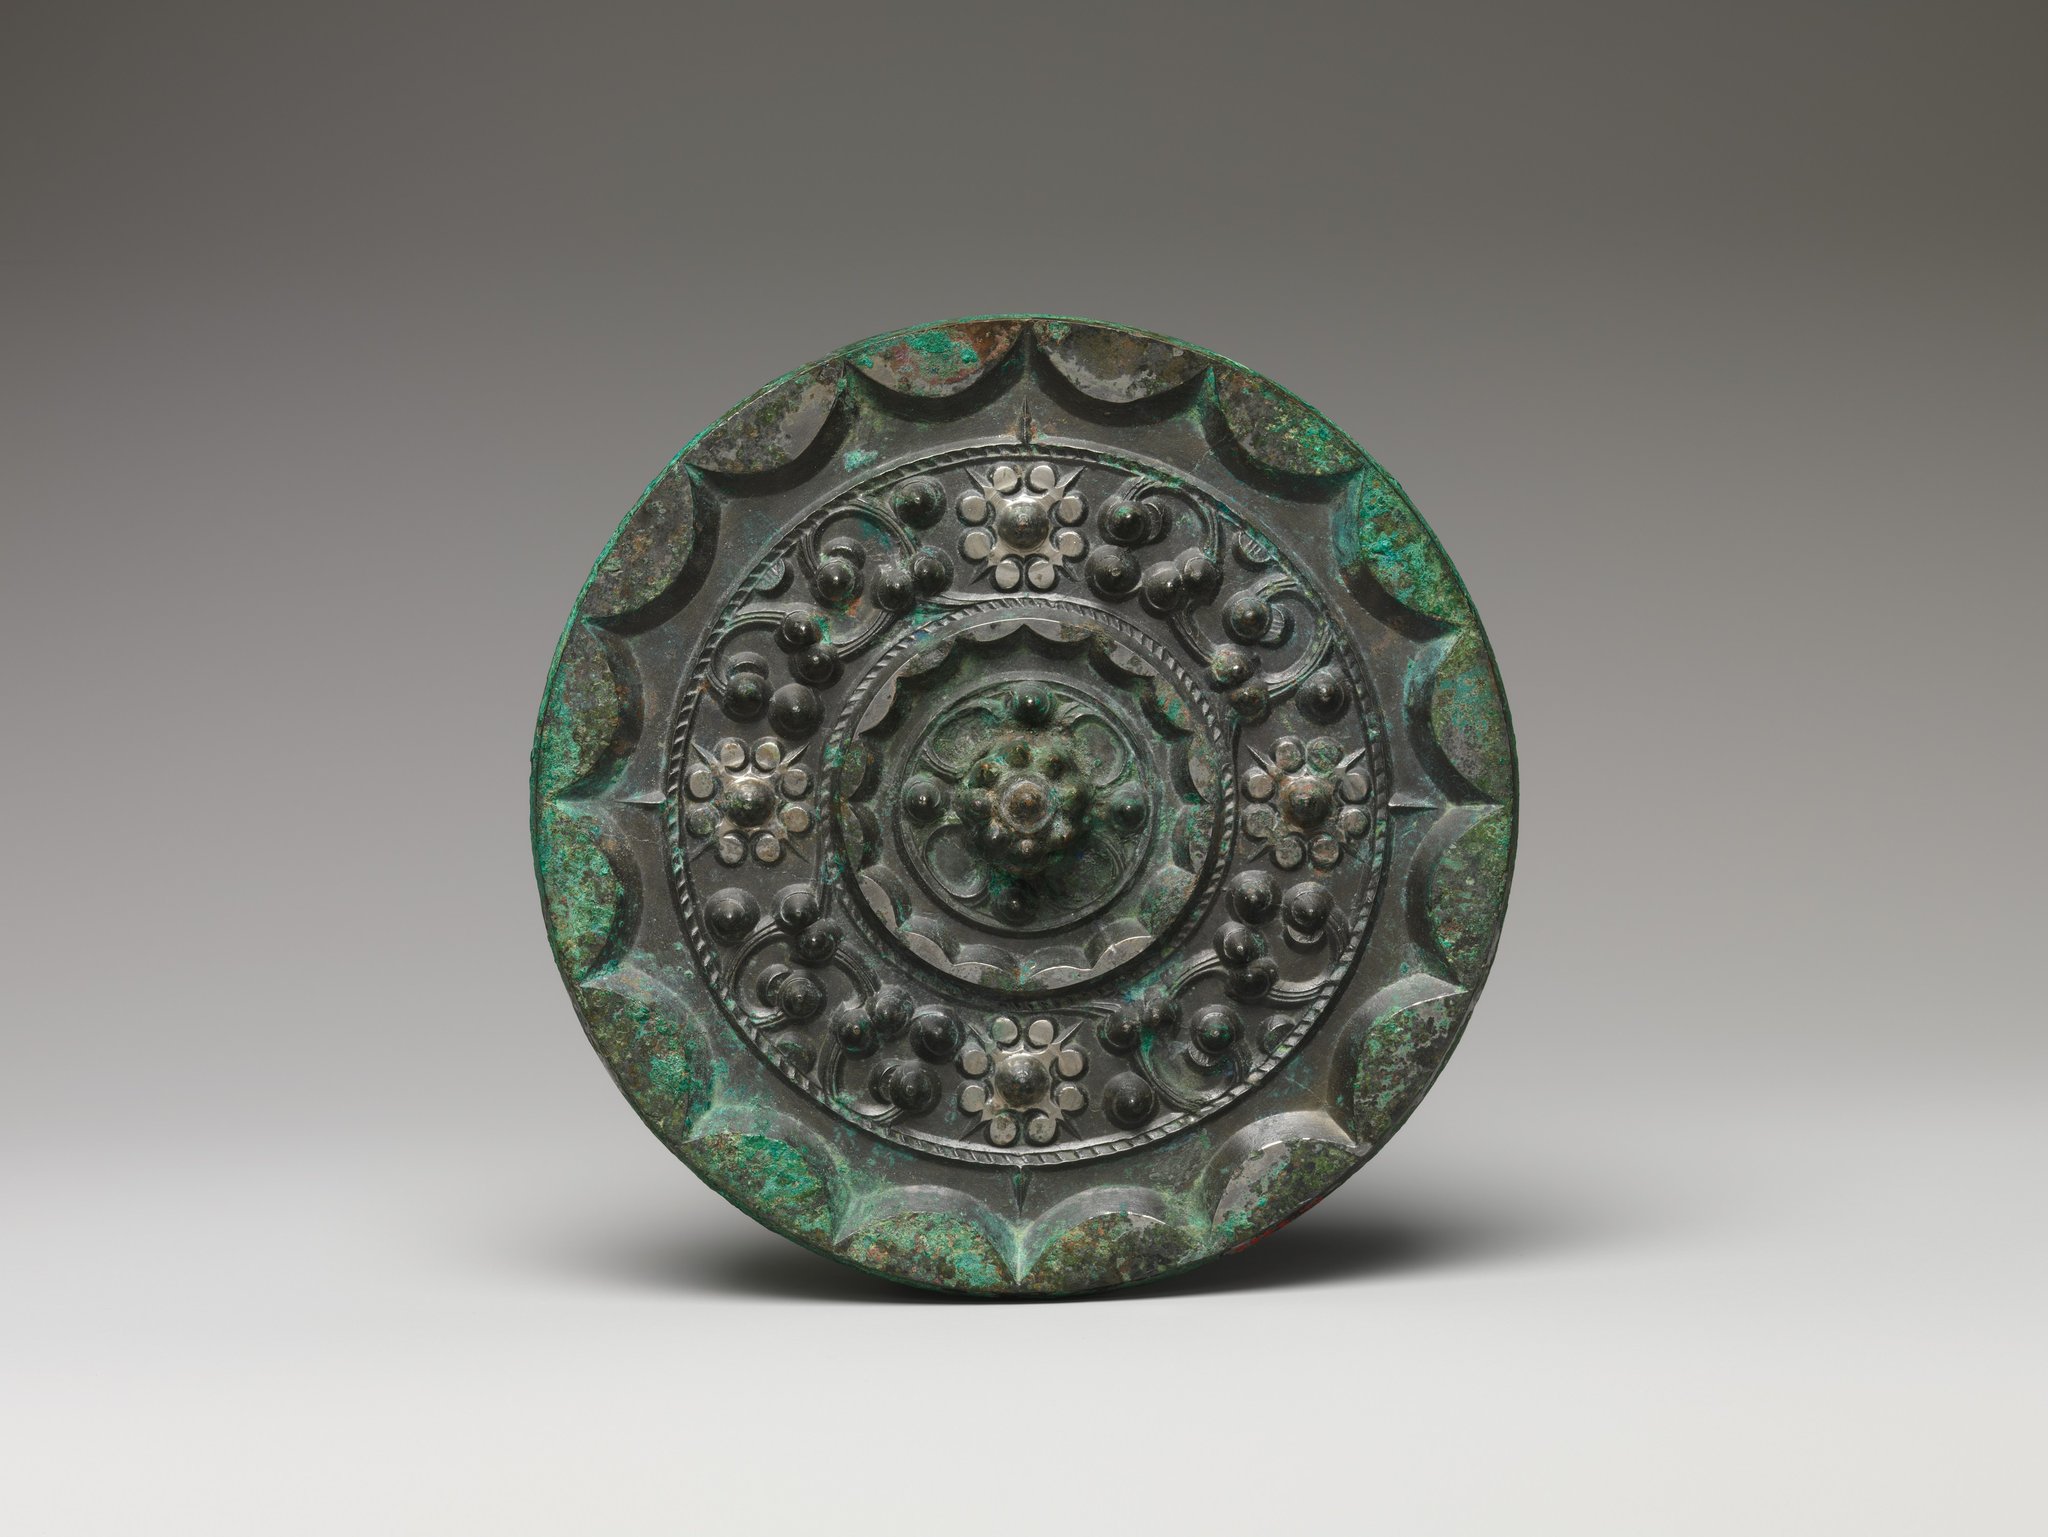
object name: mirror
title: Mirror with dragons and knob-and-swirl design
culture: chinese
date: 100-1 BCE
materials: bronze